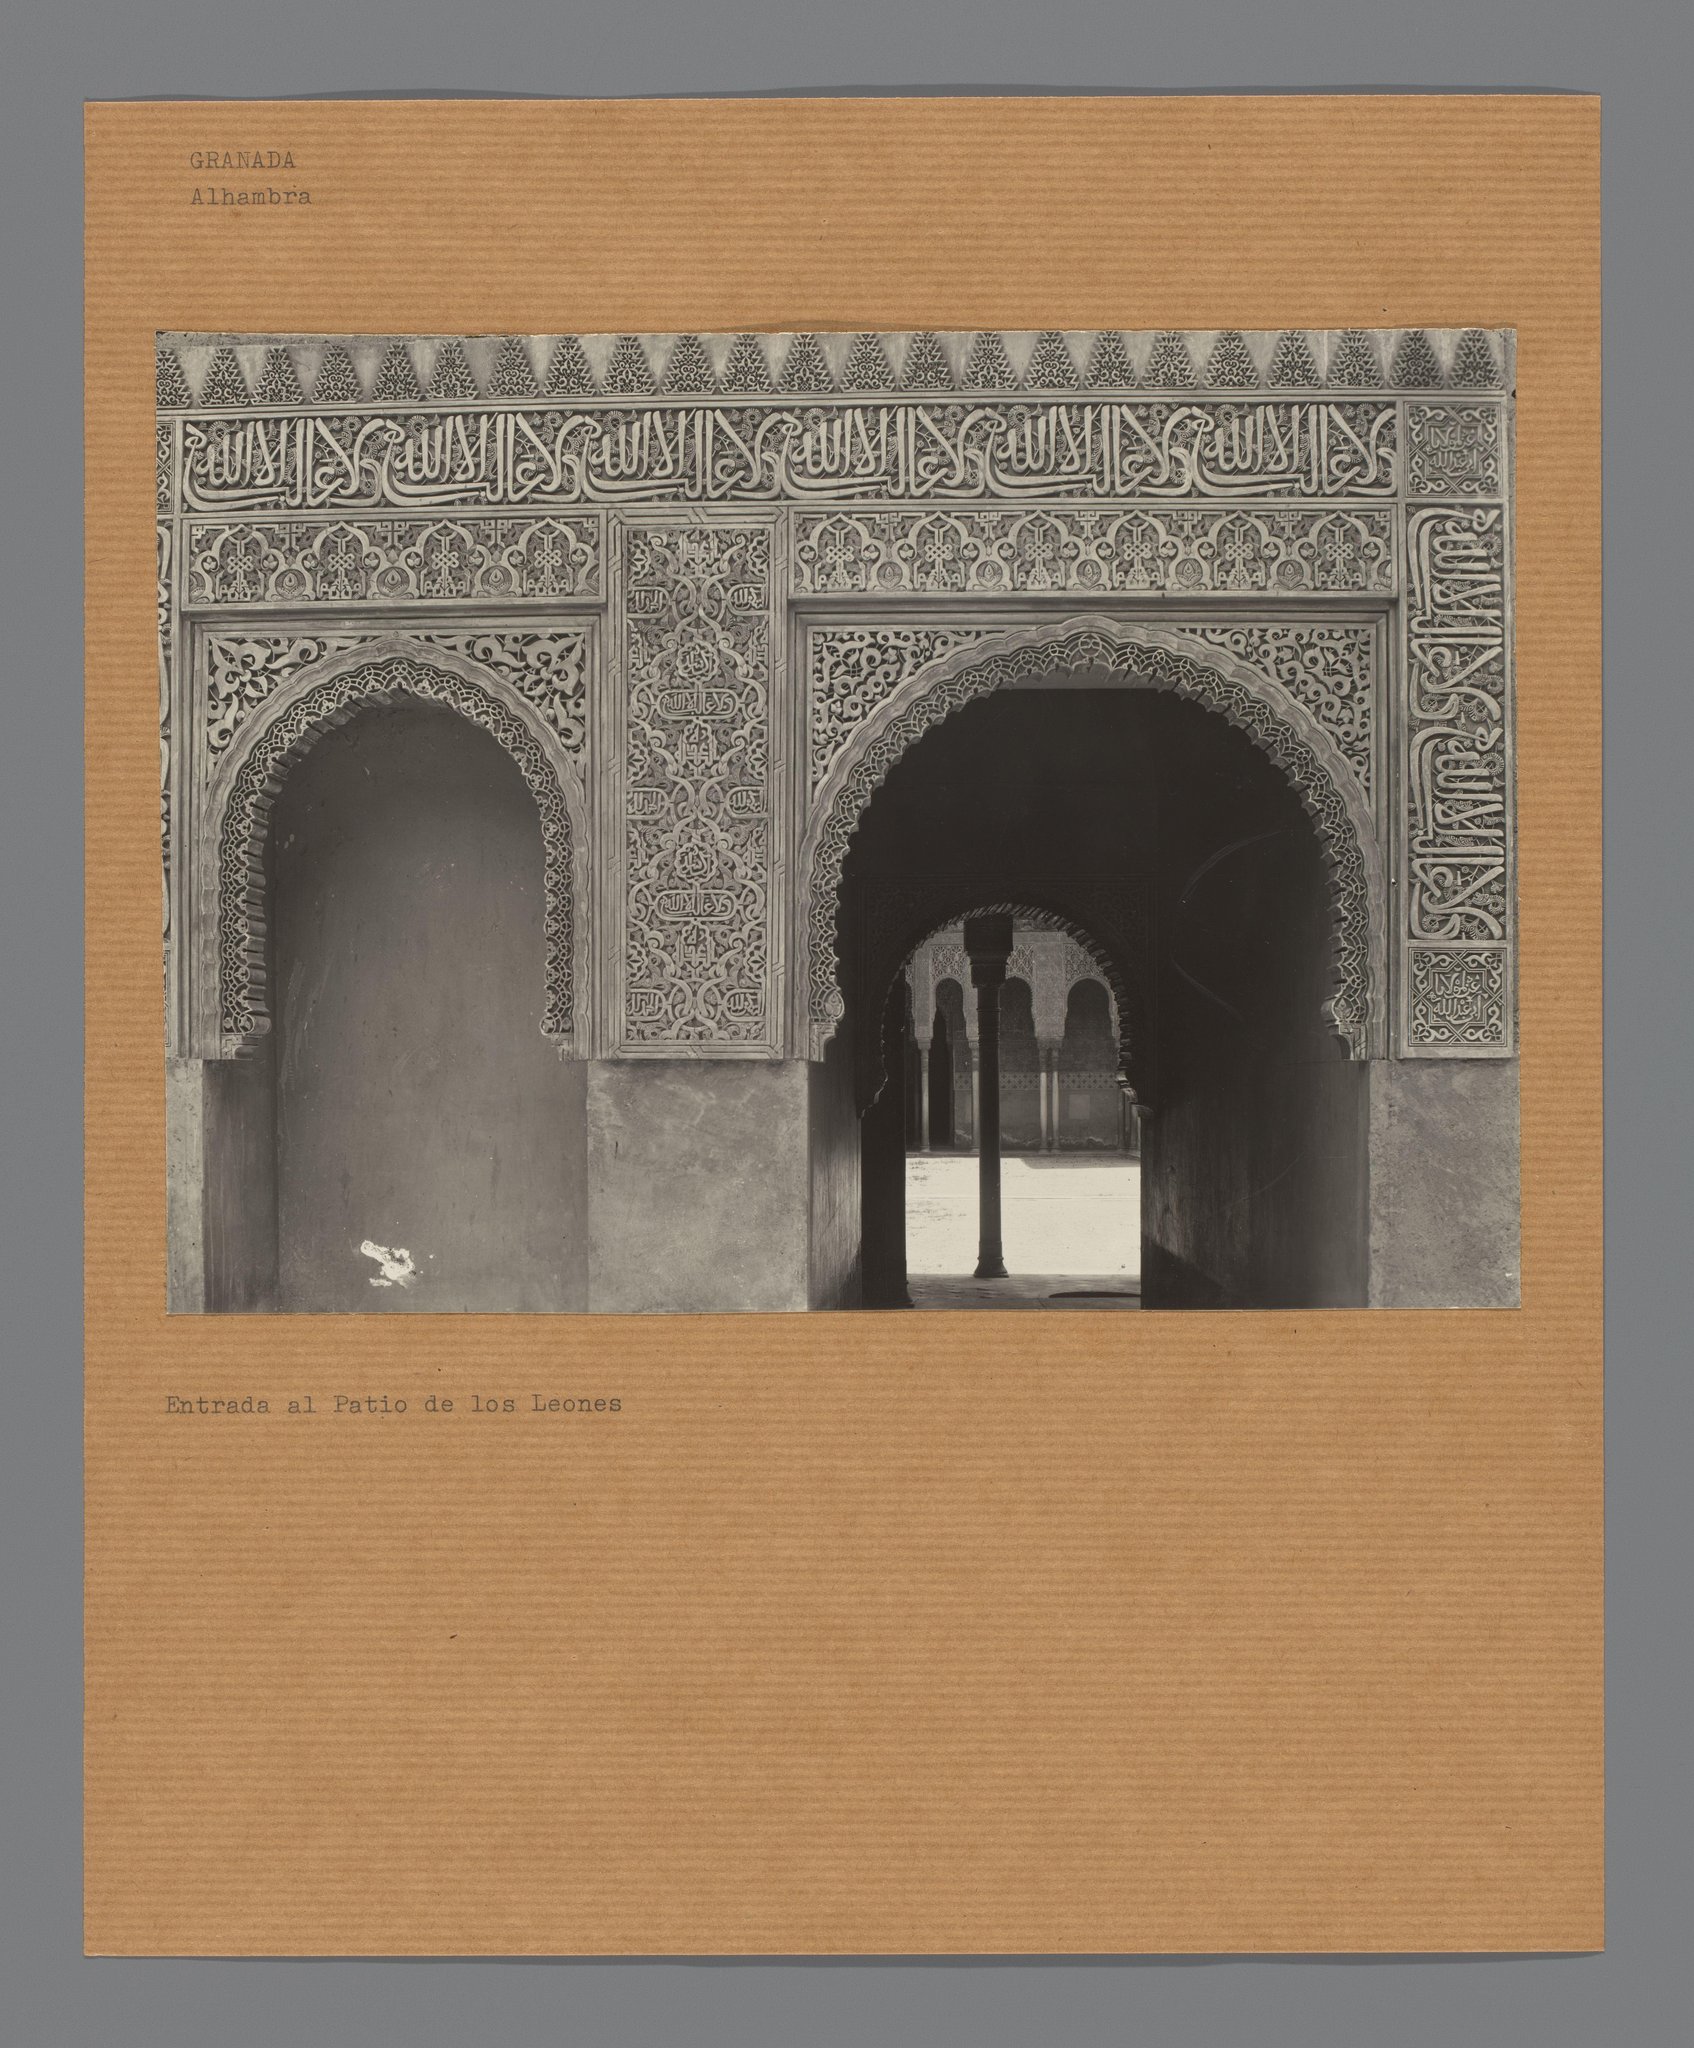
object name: photograph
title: Entrada al Patio de los Leones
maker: f. linares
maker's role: publisher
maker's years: 1870-1937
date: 1885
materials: paper, photographic support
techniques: gelatin silver print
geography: spain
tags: alhambra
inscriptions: inscription, stamp: ‘UNIVERSITEIT VAN AMSTERDAM / KUNST / HISTORISCH / INSTITUUT’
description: Foto uit de studiecollectie van het Kunsthistorisch Instituut van de Universiteit van Amsterdam.